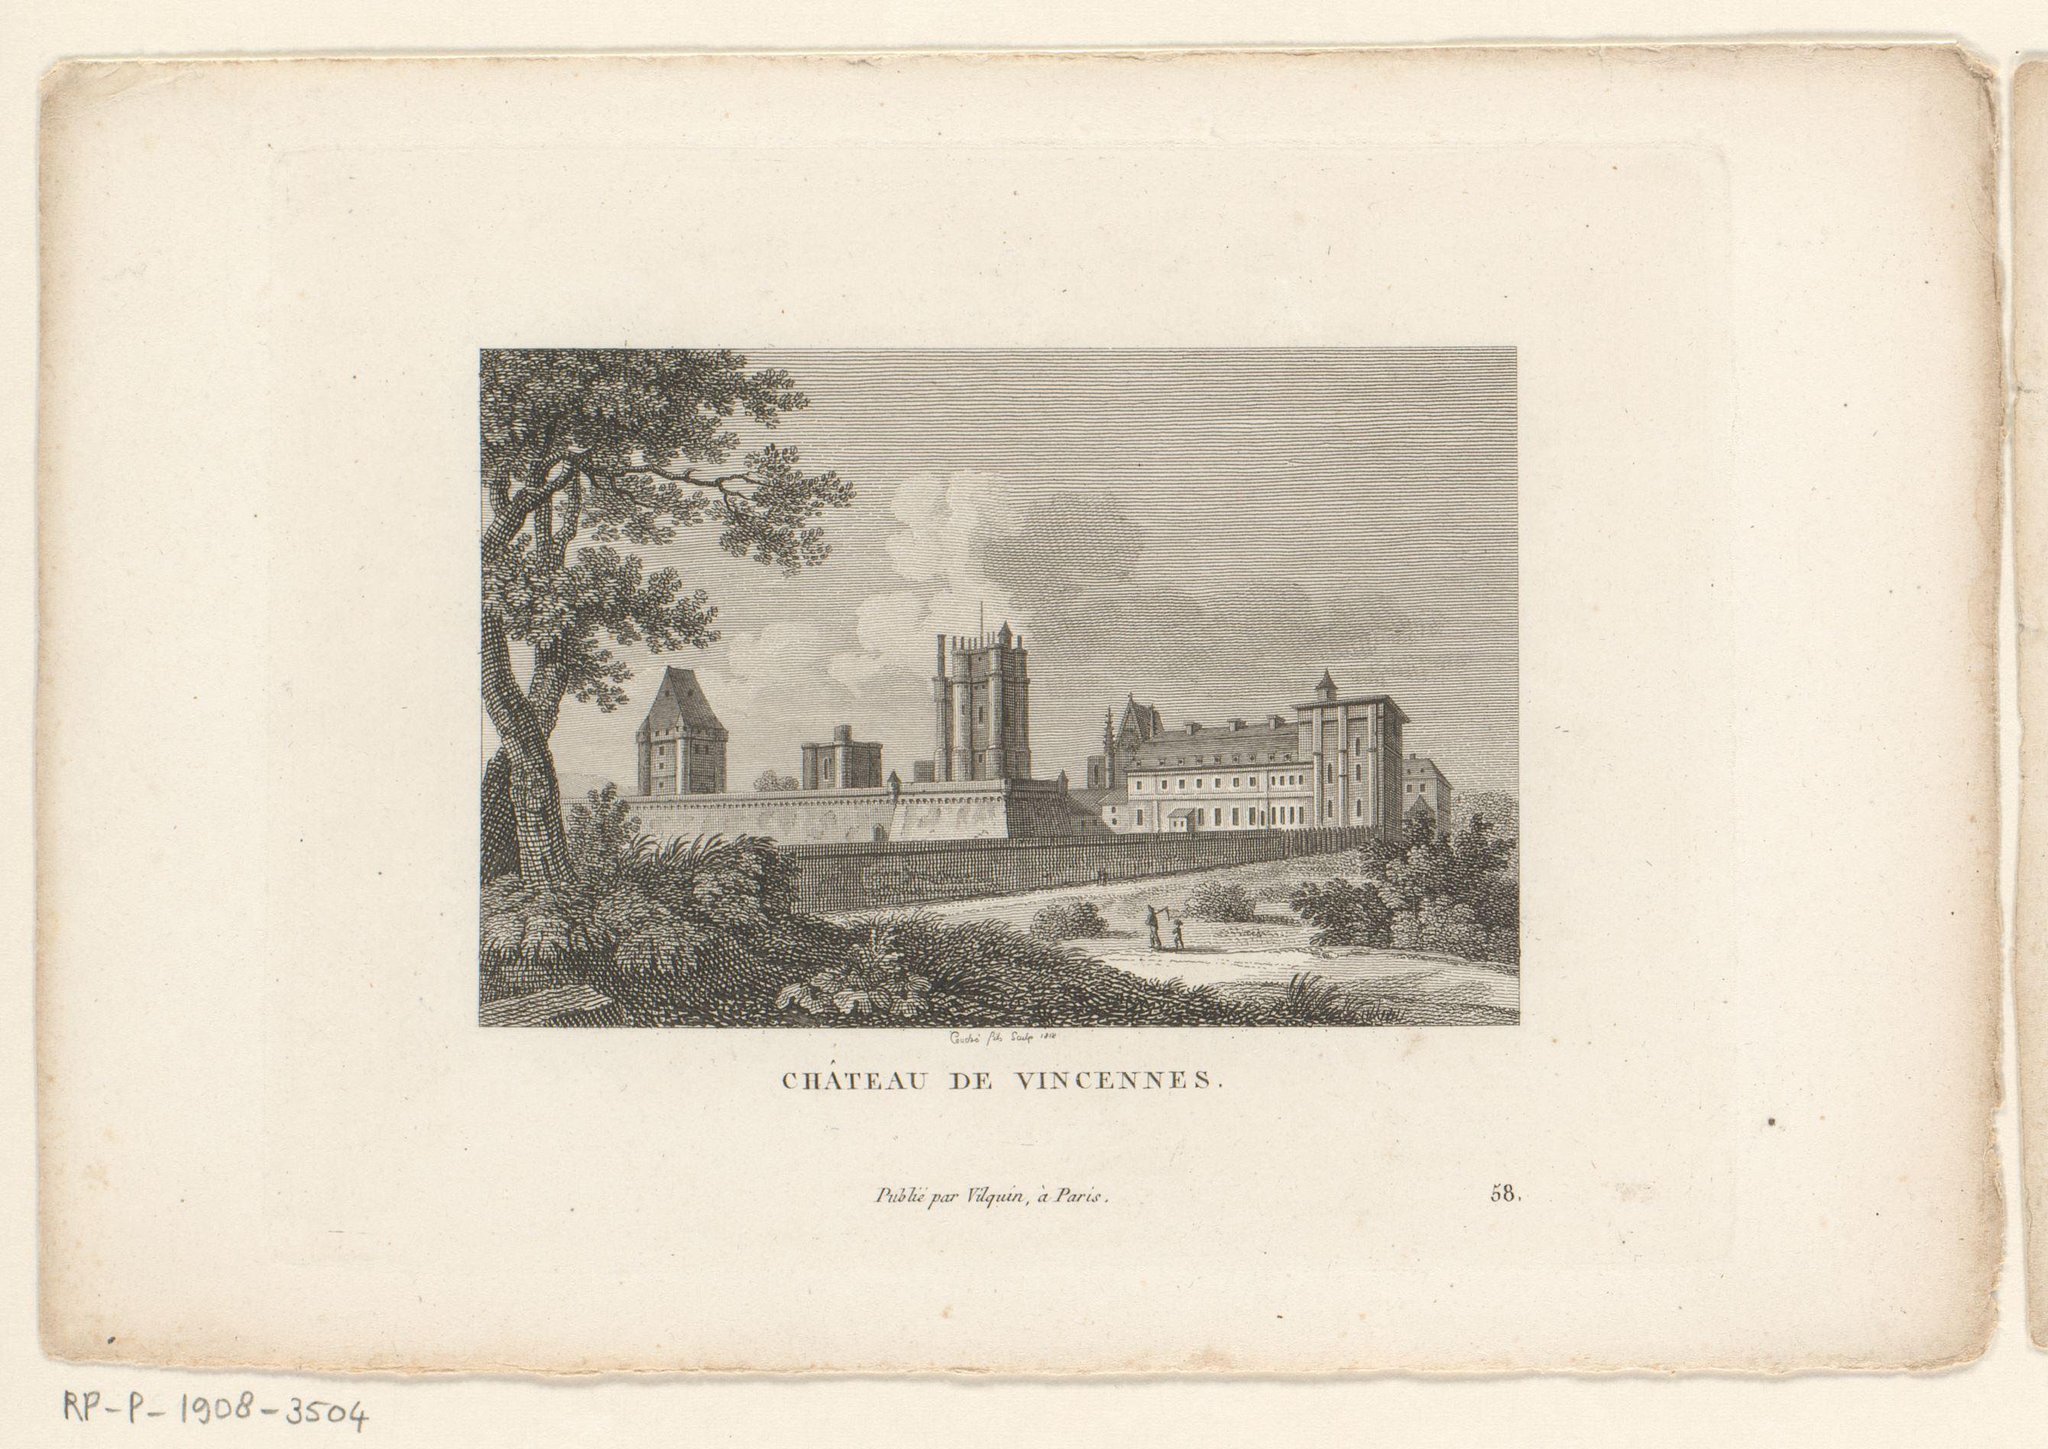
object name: print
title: Gezichten op Parijs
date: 1818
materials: paper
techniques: etching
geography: paris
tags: city-view in general; 'veduta', palace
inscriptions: collector's mark: Lugt 2228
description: Maakt deel uit van een serie met 60 platen van monumenten, kathedralen en paleizen in Parijs.